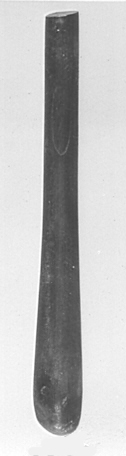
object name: kohl stick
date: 1635-1458 BCE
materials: mineral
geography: egypt